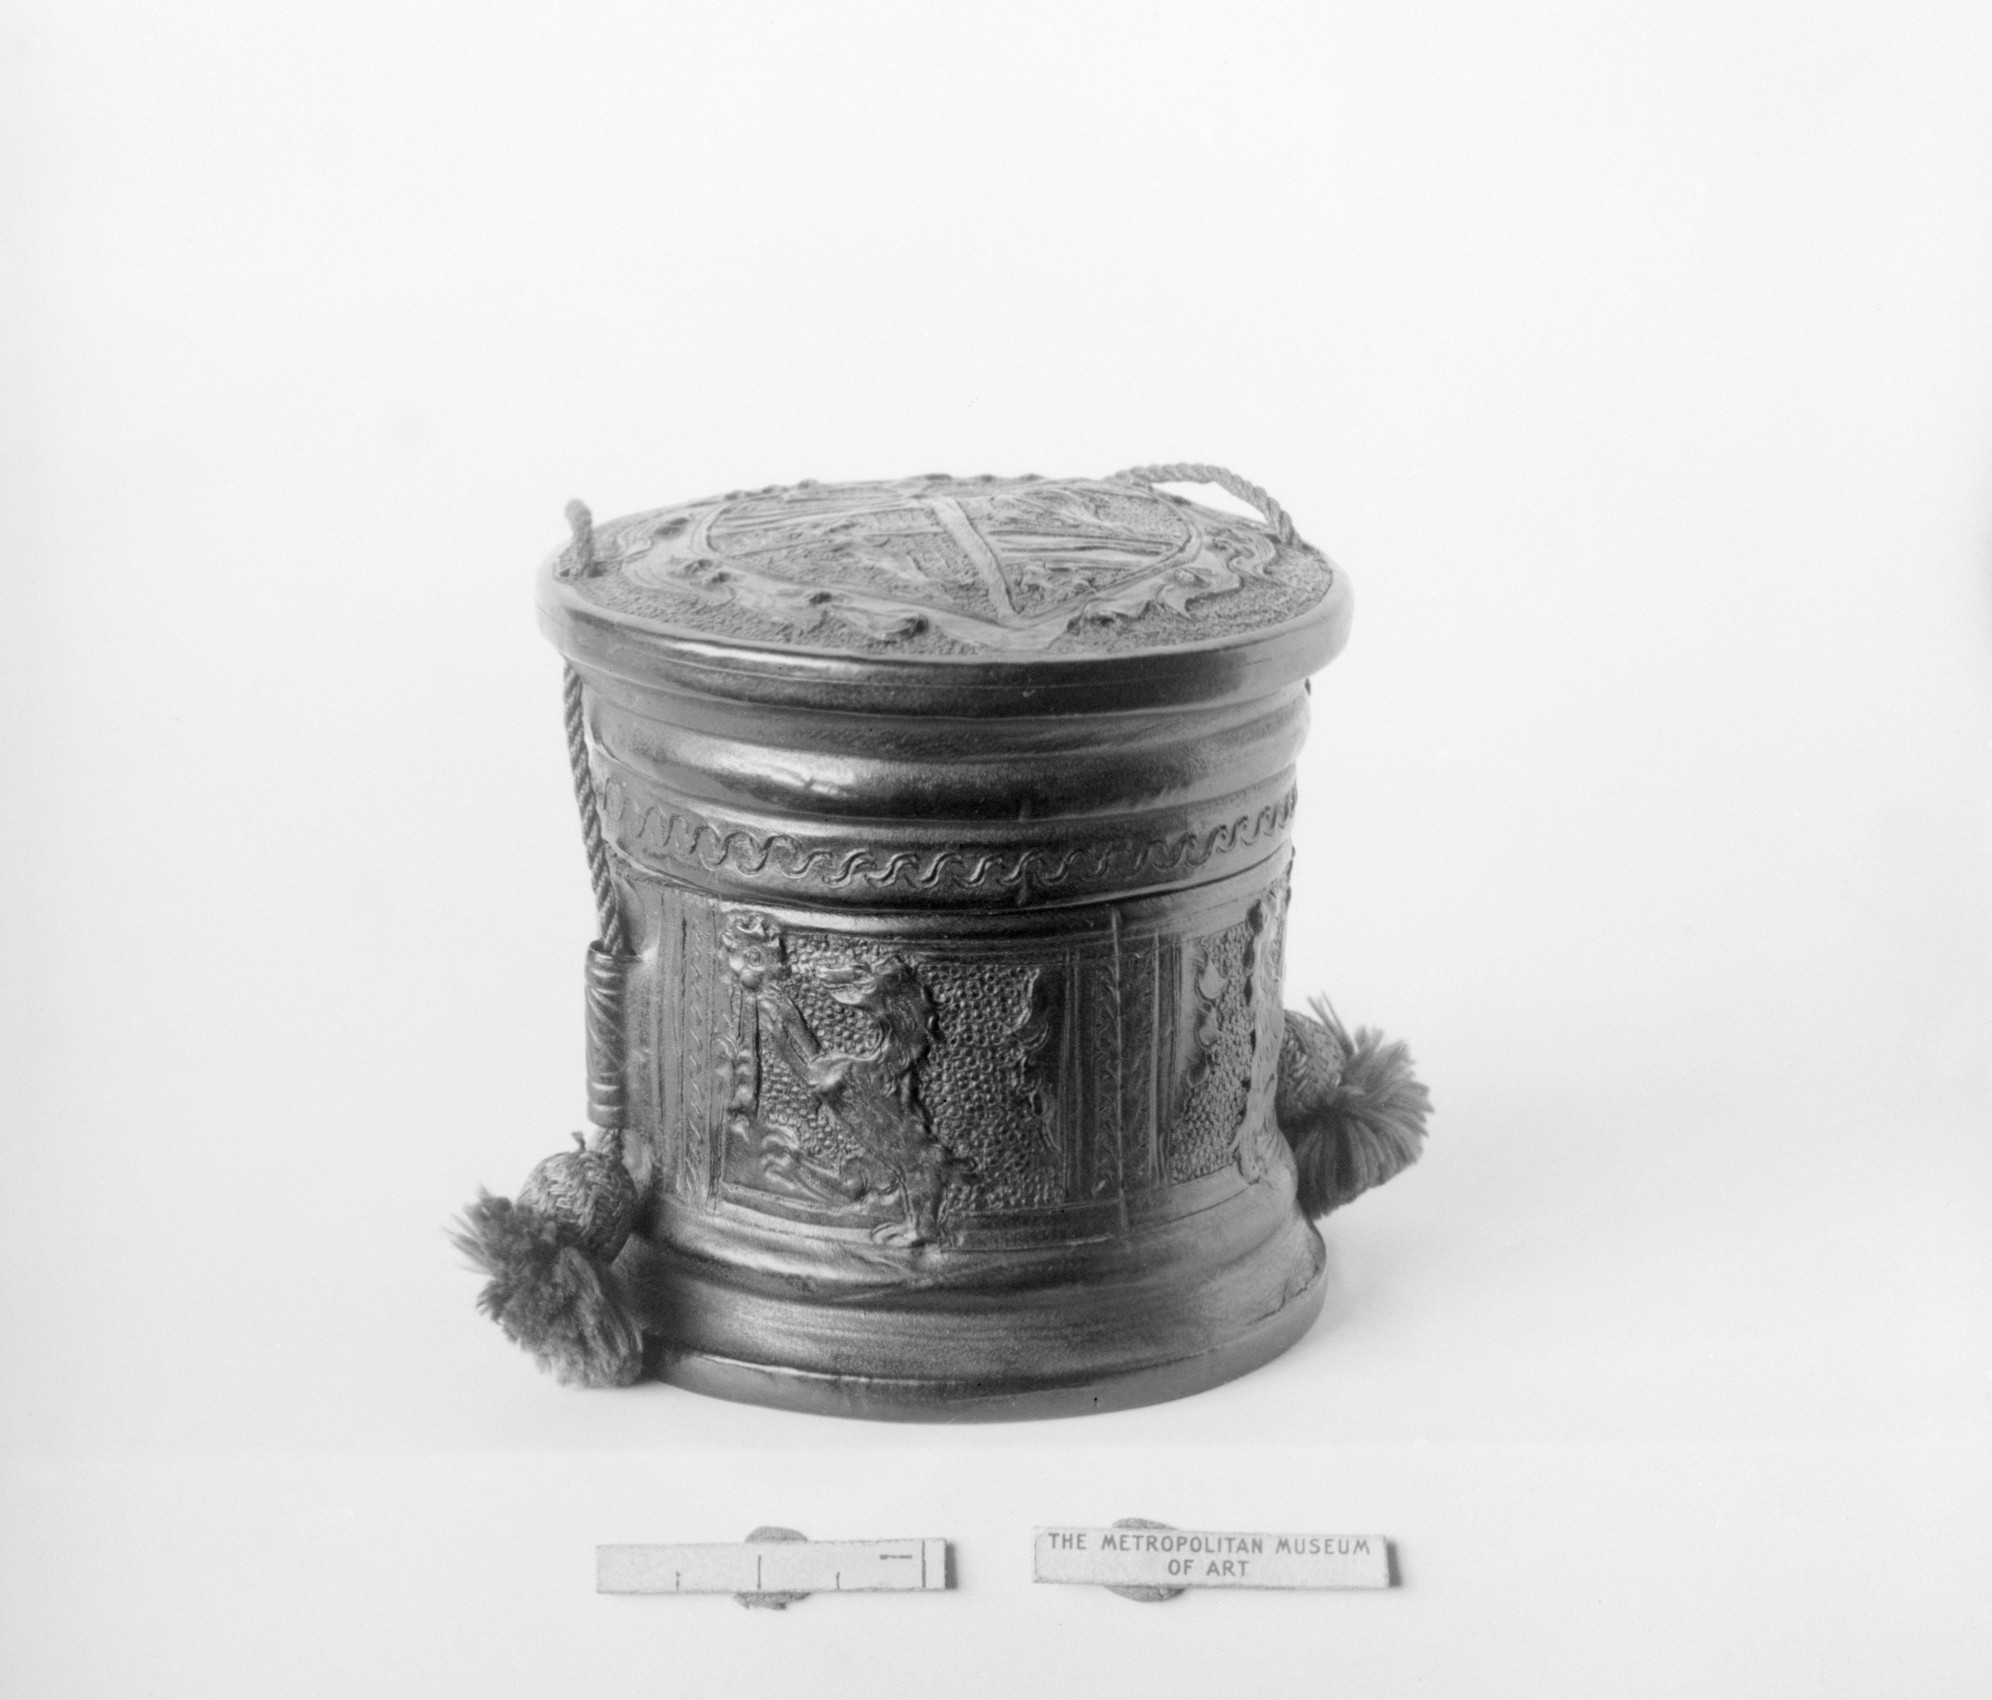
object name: clock case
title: Clock-watch case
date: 1601-1700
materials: leather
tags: dragons